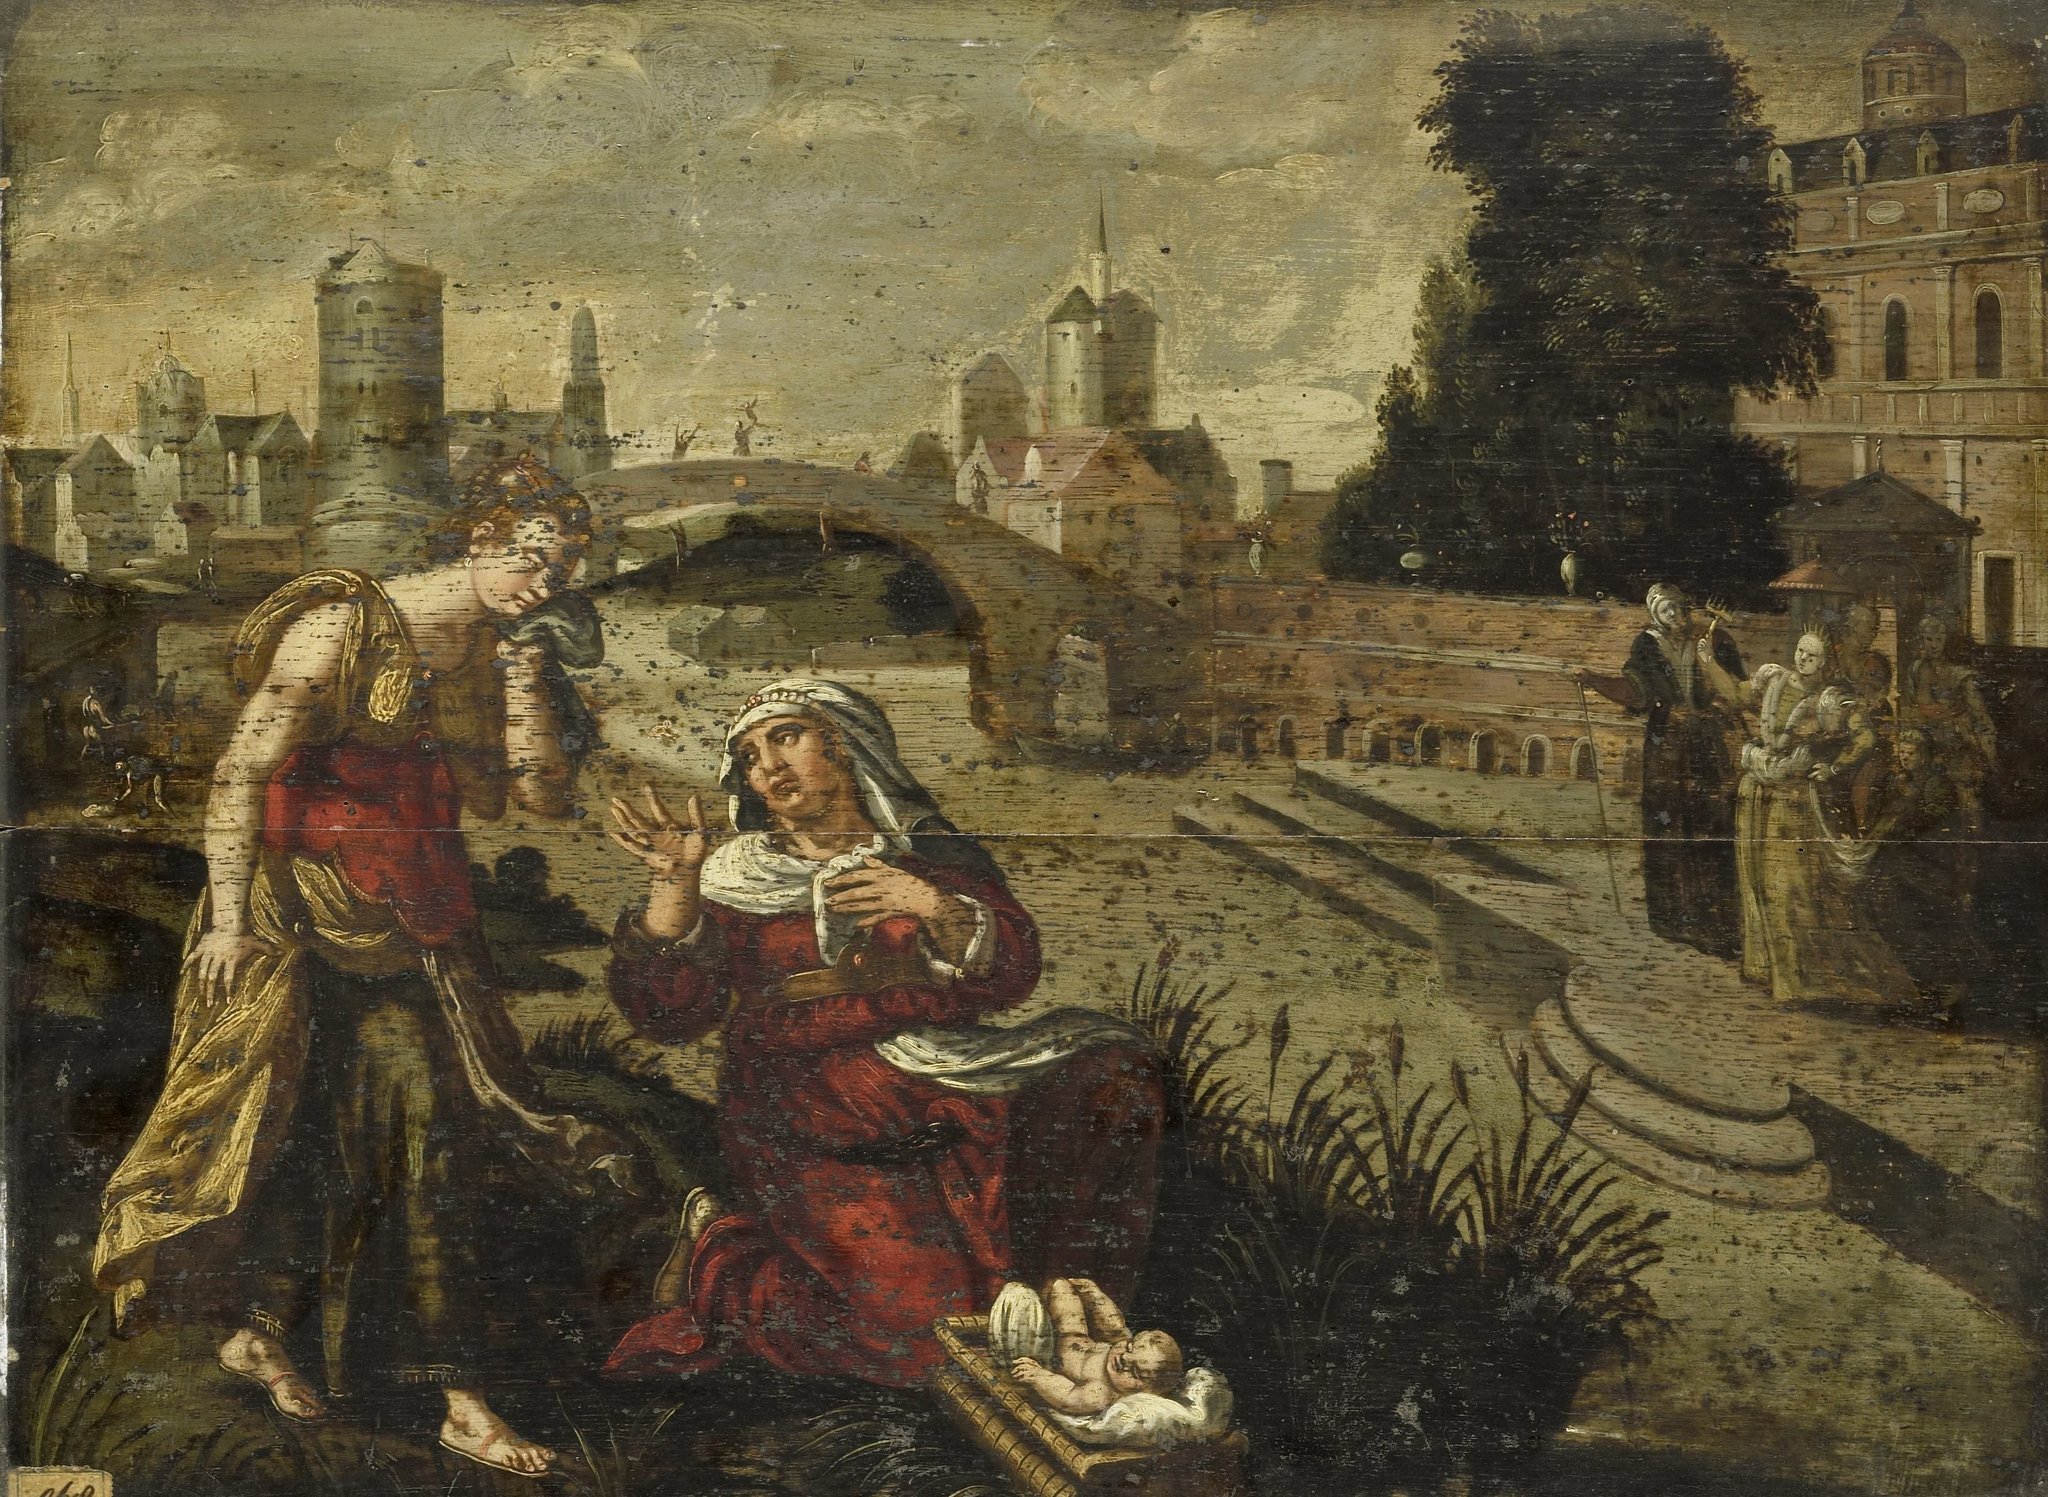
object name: painting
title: Finding of Moses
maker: Anonymous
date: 1500-1599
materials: oil, panel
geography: southern netherlands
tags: pharaoh decrees the drowning of every new male offspring among the israelites, the finding of moses: pharaoh's daughter comes to bathe with her maidens in the river and discovers the child floating on the water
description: De moeder van Mozes knielt bij het biezen mandje waarin zij haar zoon Mozes te water laat. Naast haar staat Mirjam, de zus van Mozes. Links aan de oever van de Nijl staat de dochter van farao met haar gevolg. Zij zal Mozes vinden. Op de achtergrond worden vanaf de brug Hebreeuwse baby's in de Nijl gegooid.